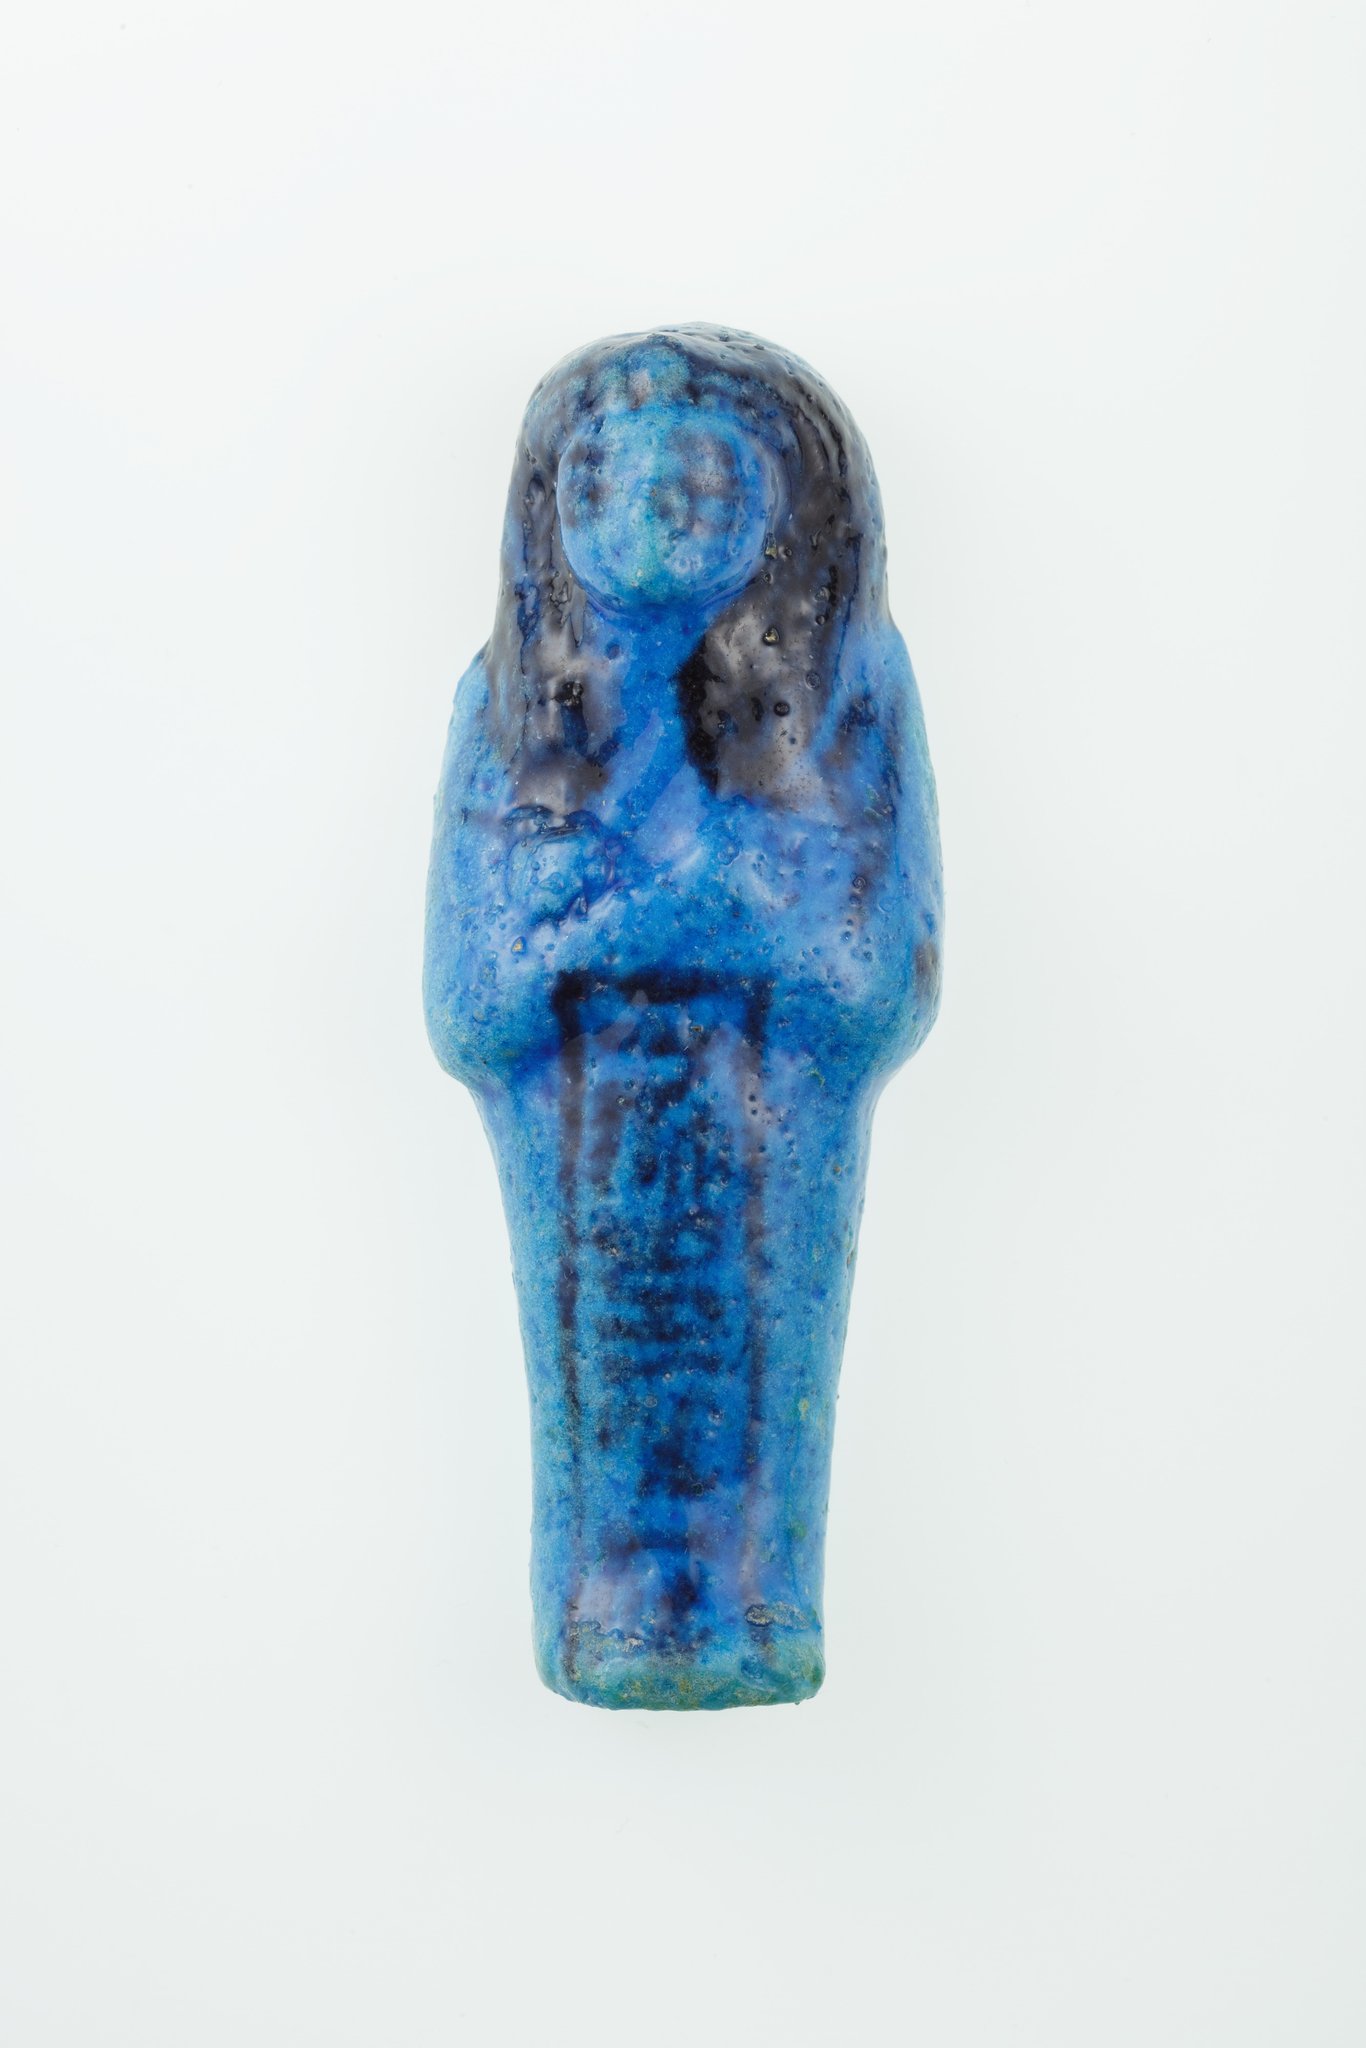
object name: shabti, worker, nauny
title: Worker Shabti of Nauny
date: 1050 BCE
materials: faience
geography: egypt